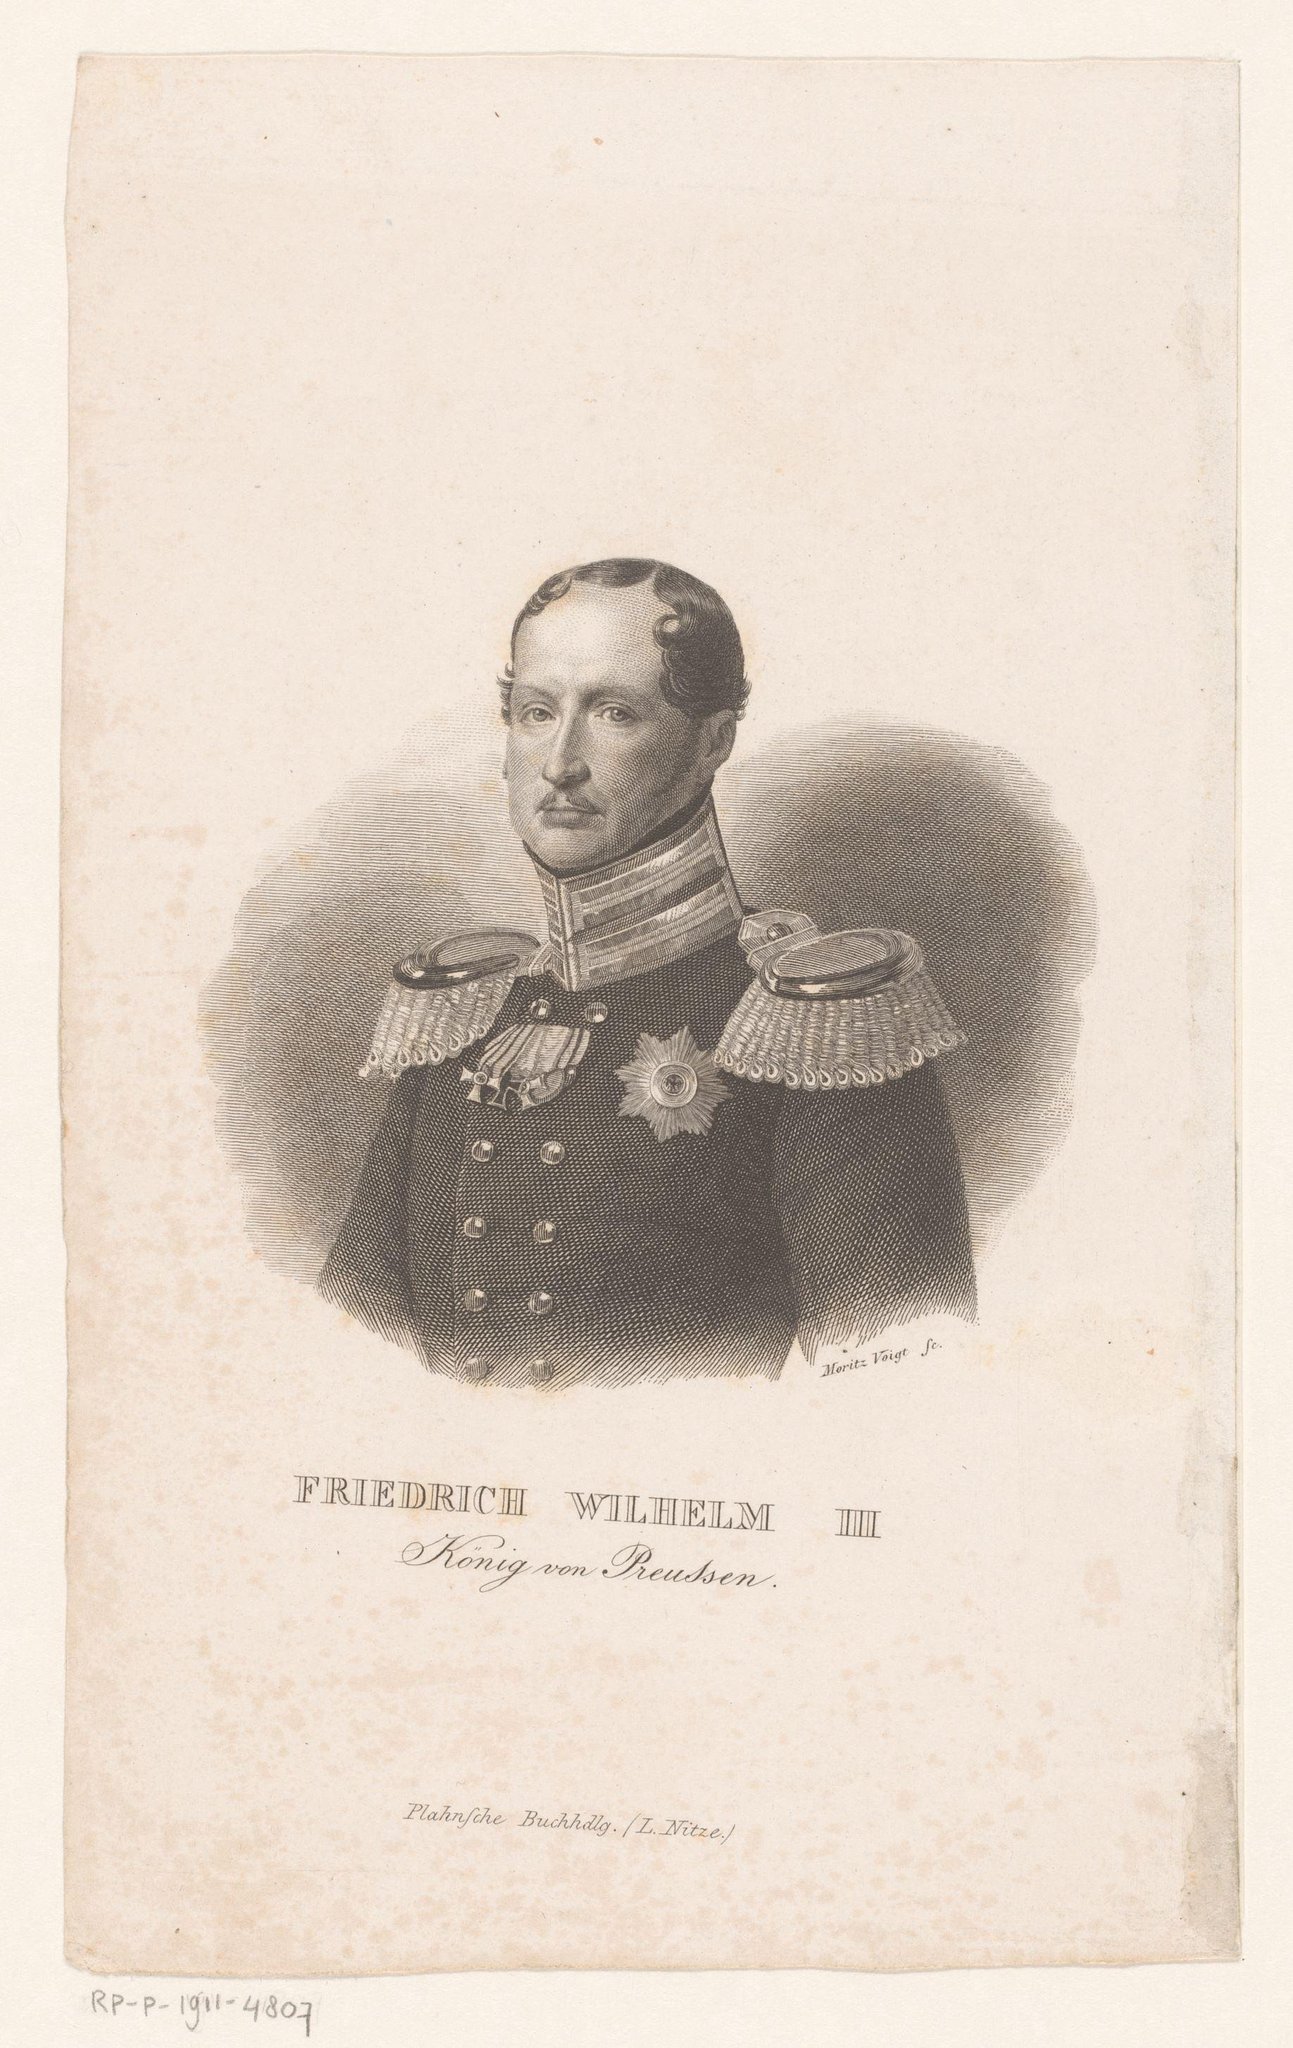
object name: print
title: Portret van Frederik Willem III, koning van Pruisen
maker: moritz voigt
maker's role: print maker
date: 1797-1840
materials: paper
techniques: engraving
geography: germany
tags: berlin, frederik willem iii koning van pruisen, historical persons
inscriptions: collector's mark: Lugt 2228